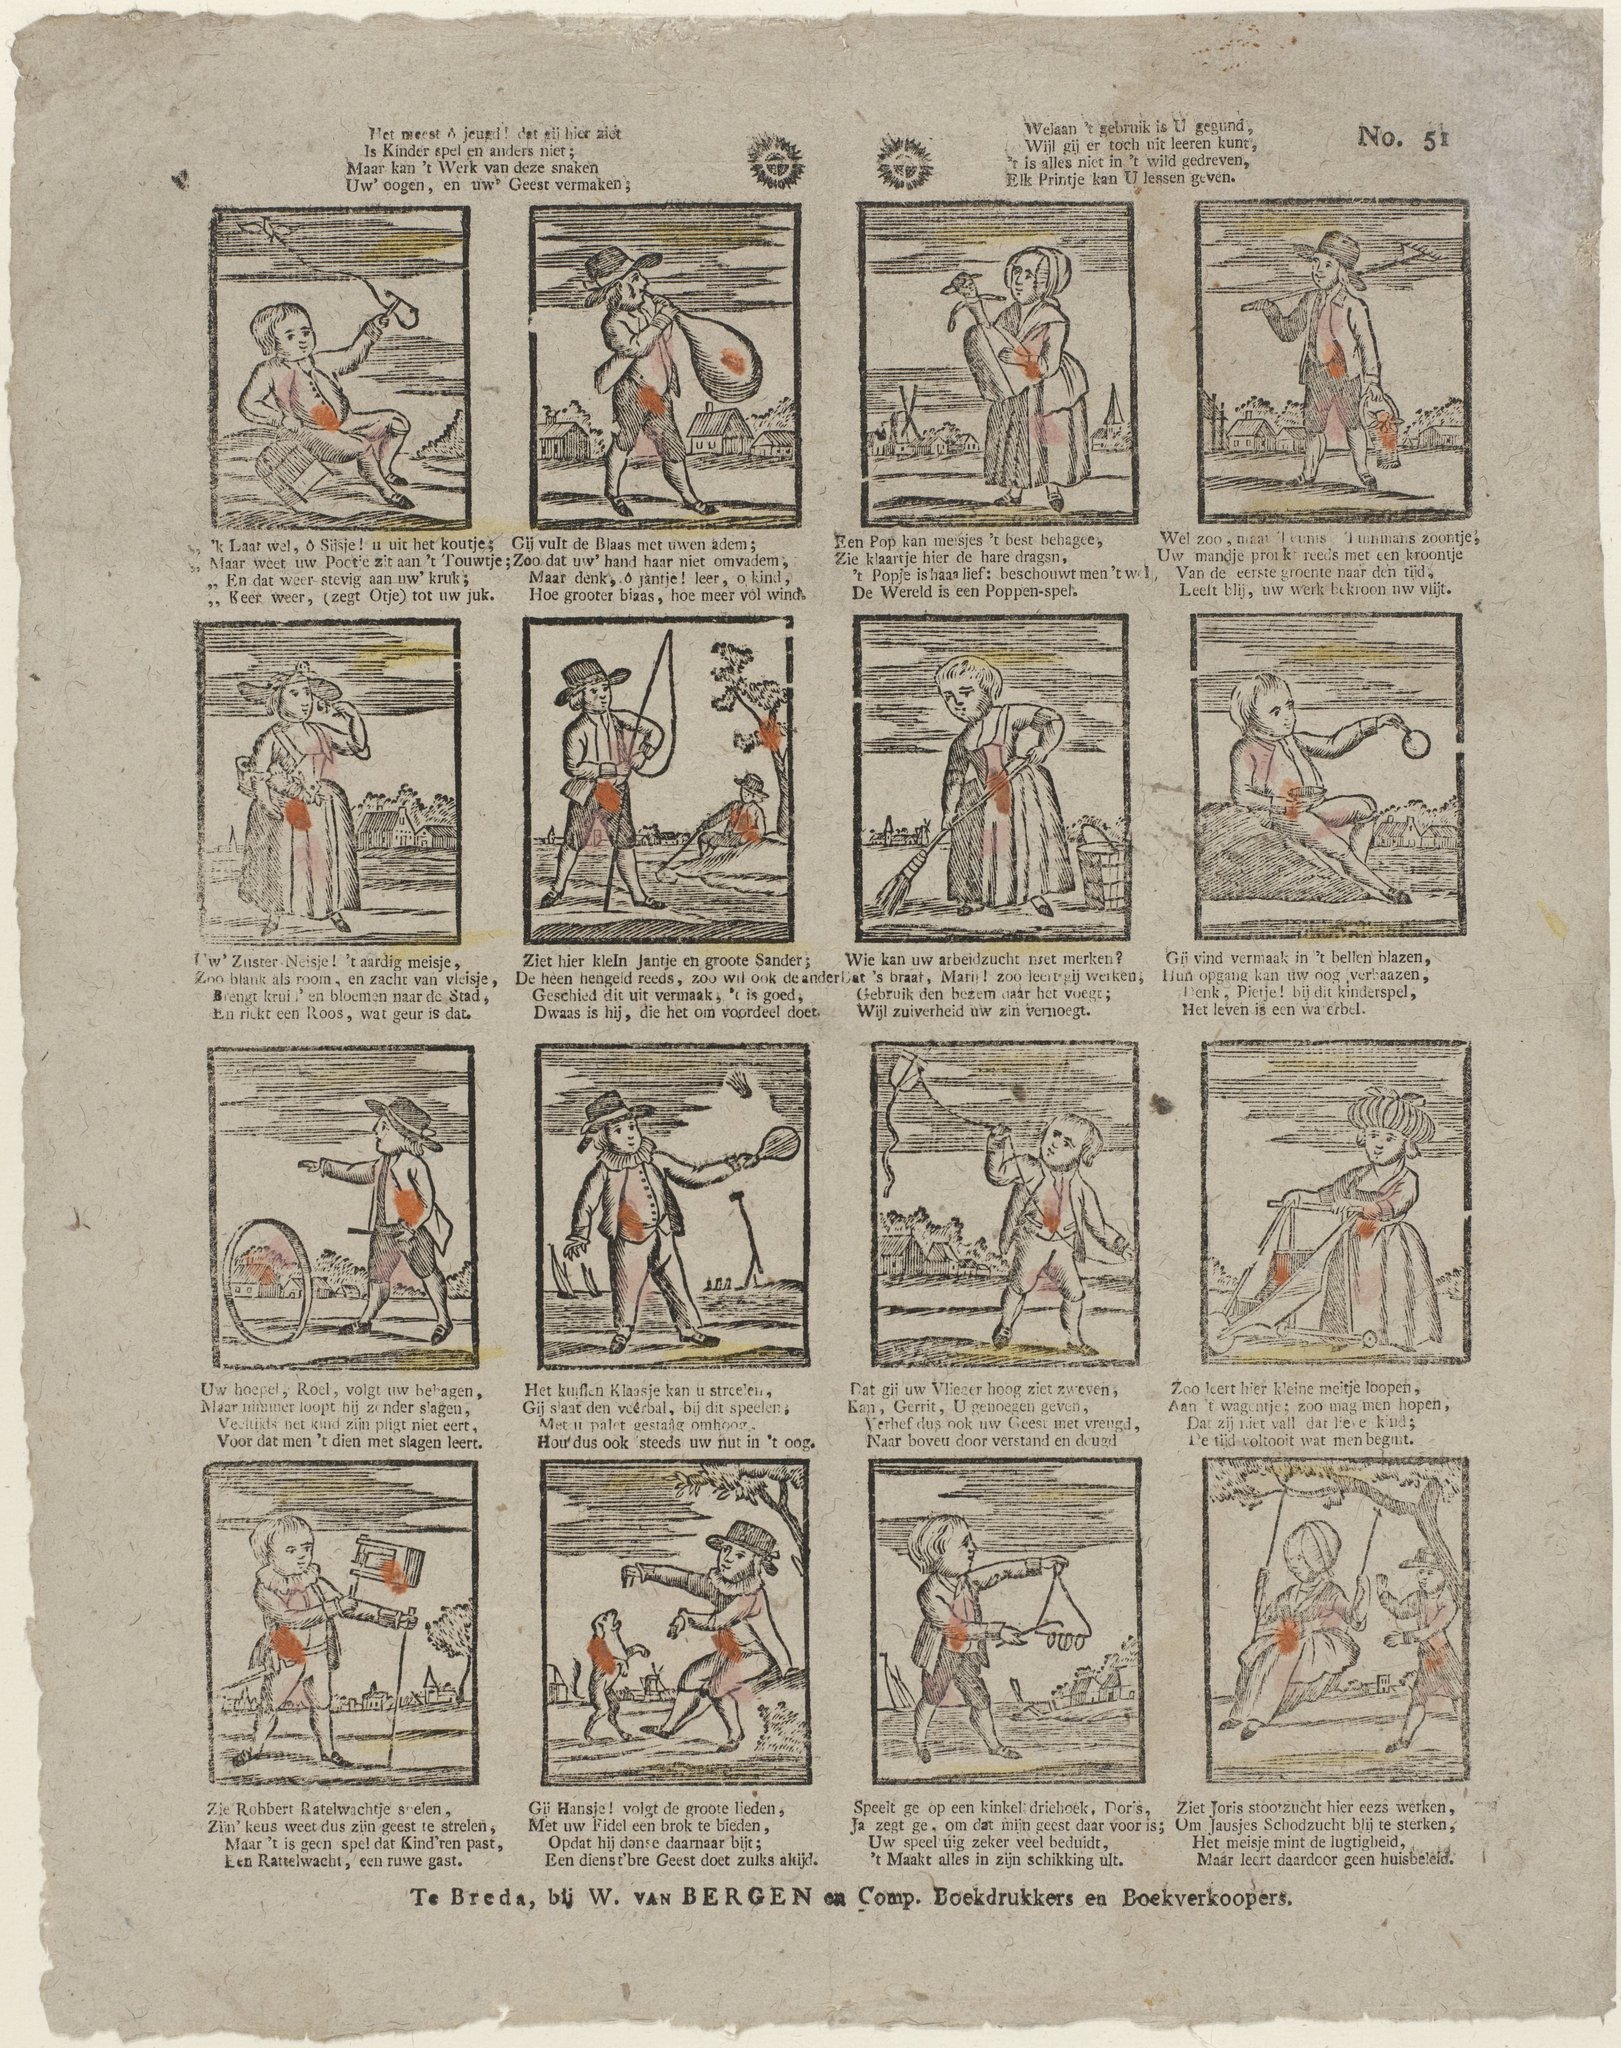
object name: popular print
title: Het meest ô jeugd! dat gy hier' ziet / Is kinder spel en anders niet (...)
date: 1818-1828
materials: paper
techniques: colour, letterpress printing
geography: breda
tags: children's games and plays, (playing with) toys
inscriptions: collector's mark: Lugt 2760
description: Blad met 16 voorstellingen van verschillende kinderspelen, zoals spelen met poppen, hoepelen en vliegeren. Onder elke afbeelding een vierregelig vers. Genummerd rechtboven: No. 51.